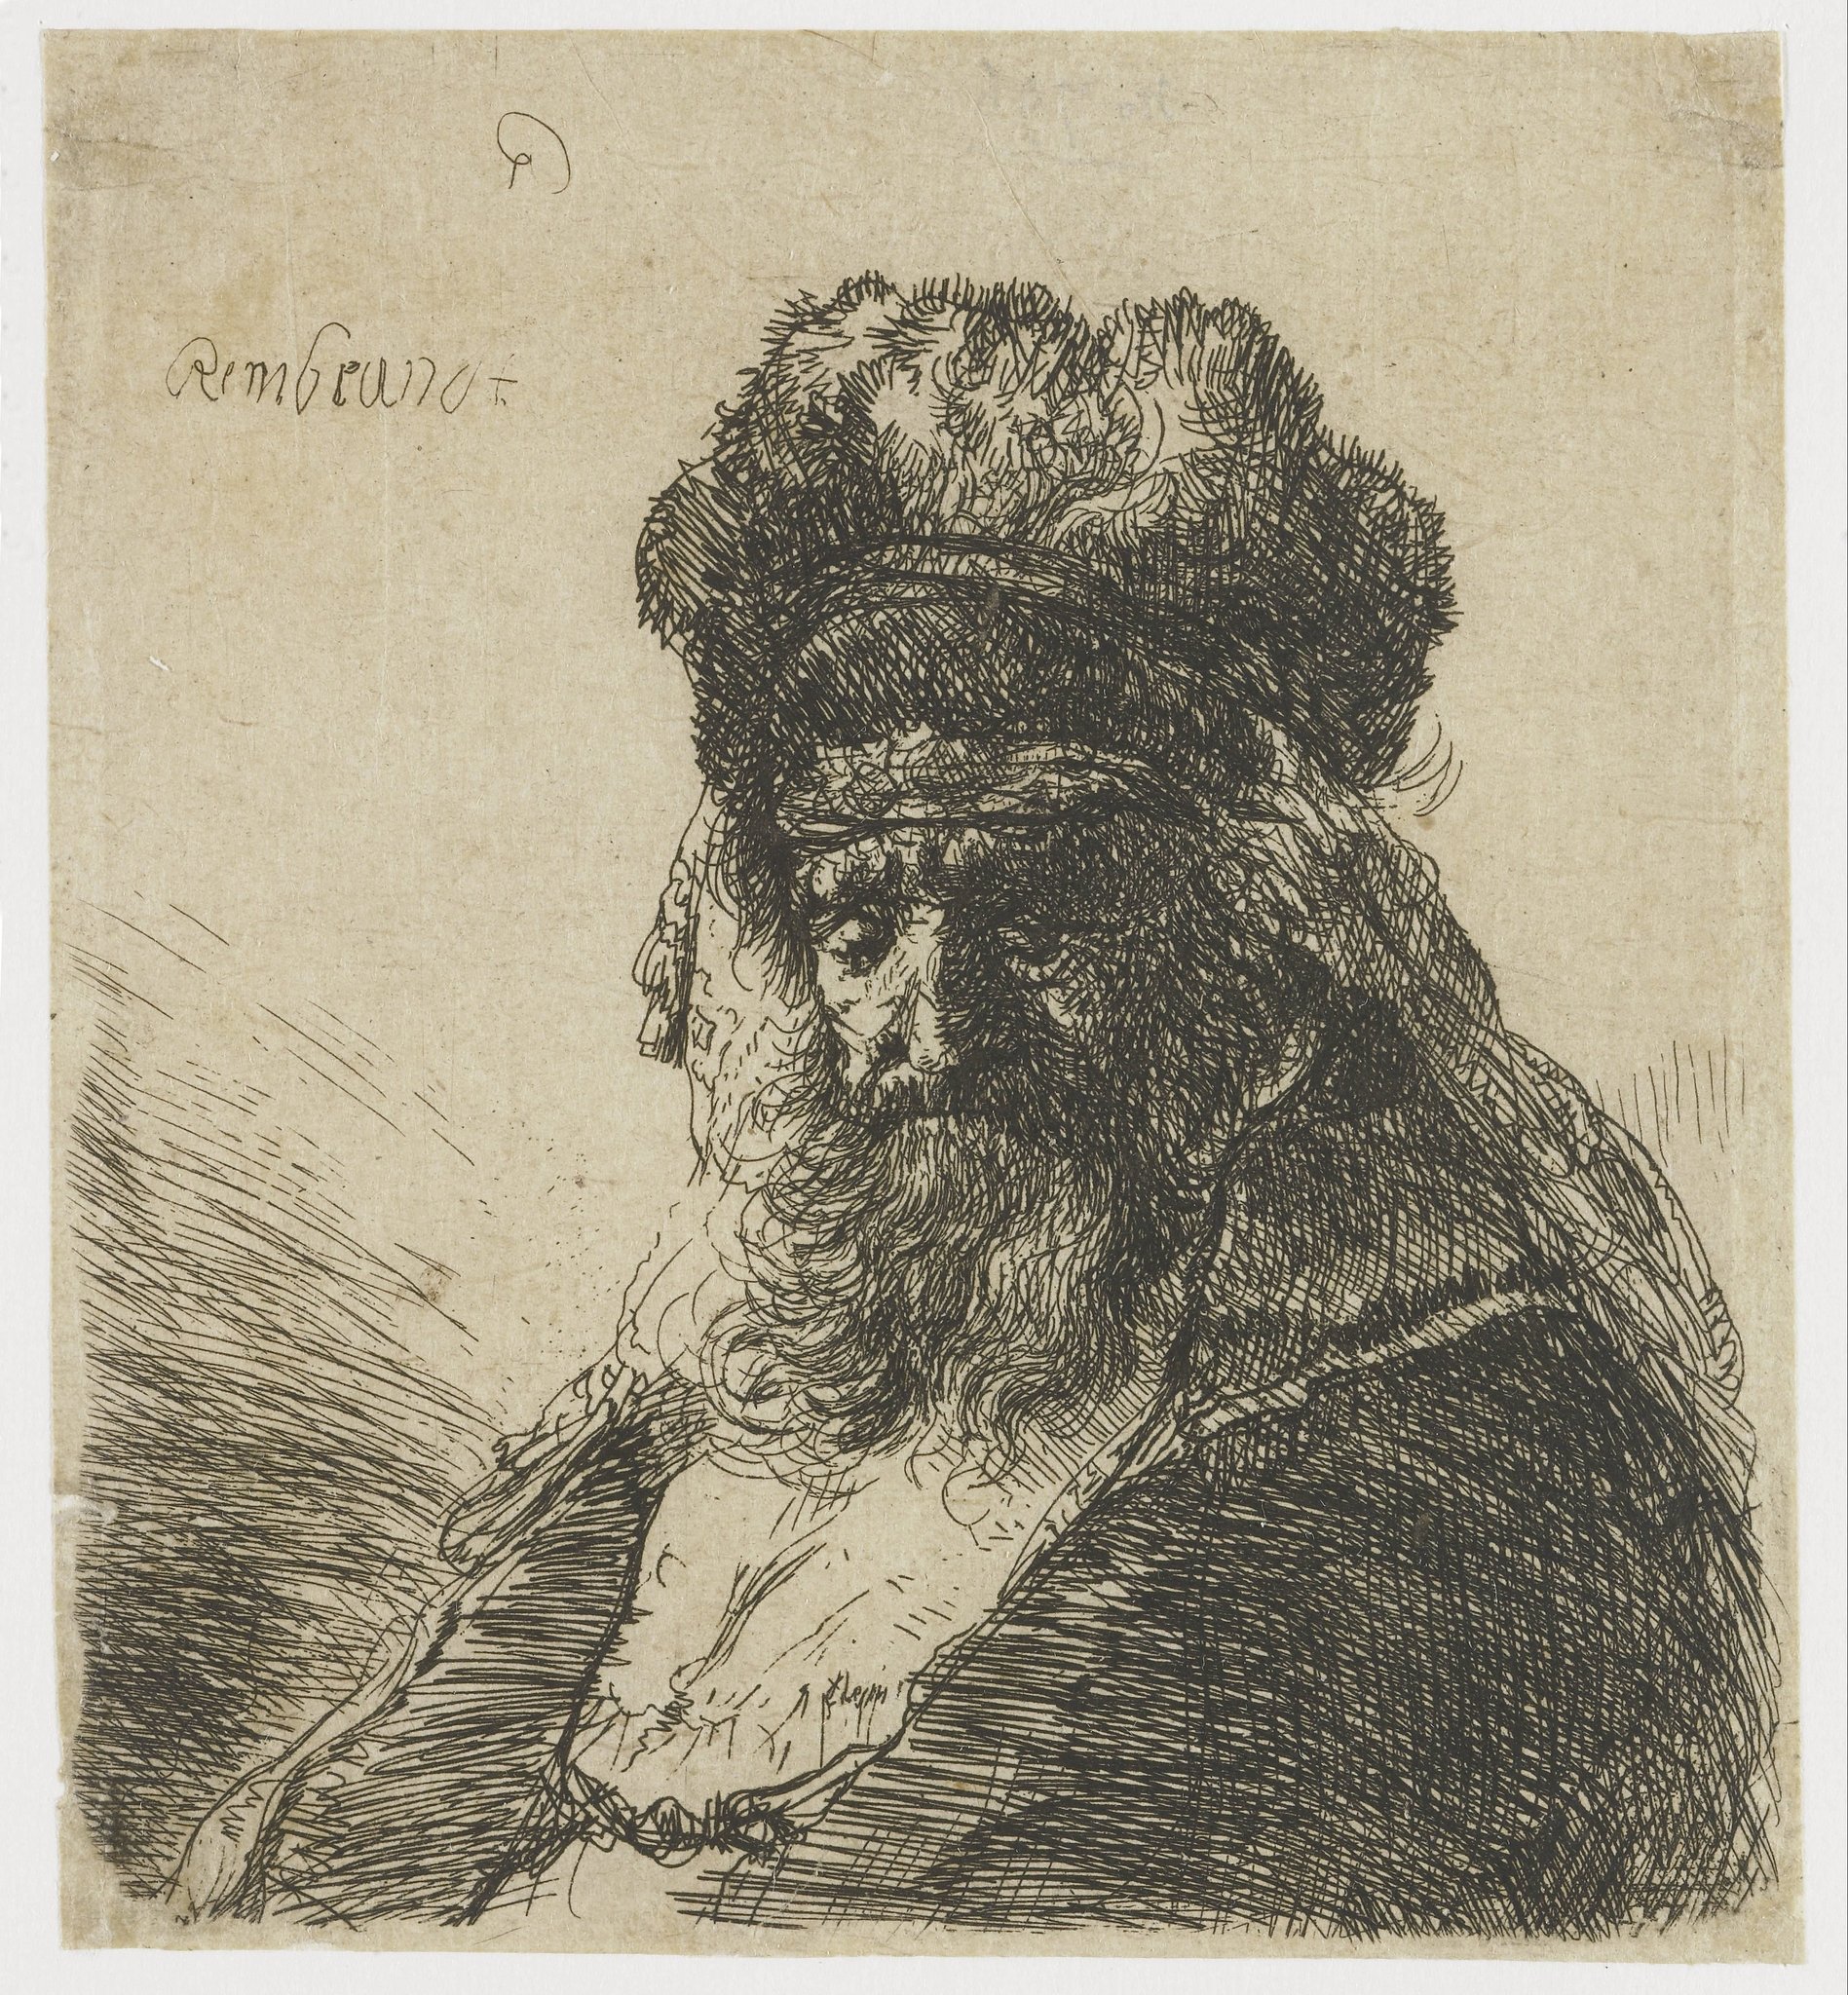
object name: print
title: Bearded old man in a high fur cap, with eyes closed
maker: rembrandt van rijn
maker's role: draughtsman, painter, print maker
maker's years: 1606-1669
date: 1635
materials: paper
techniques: etching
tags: head-gear (with name)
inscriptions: signature: ‘Rembrandt’, mark: Lugt 2228 a